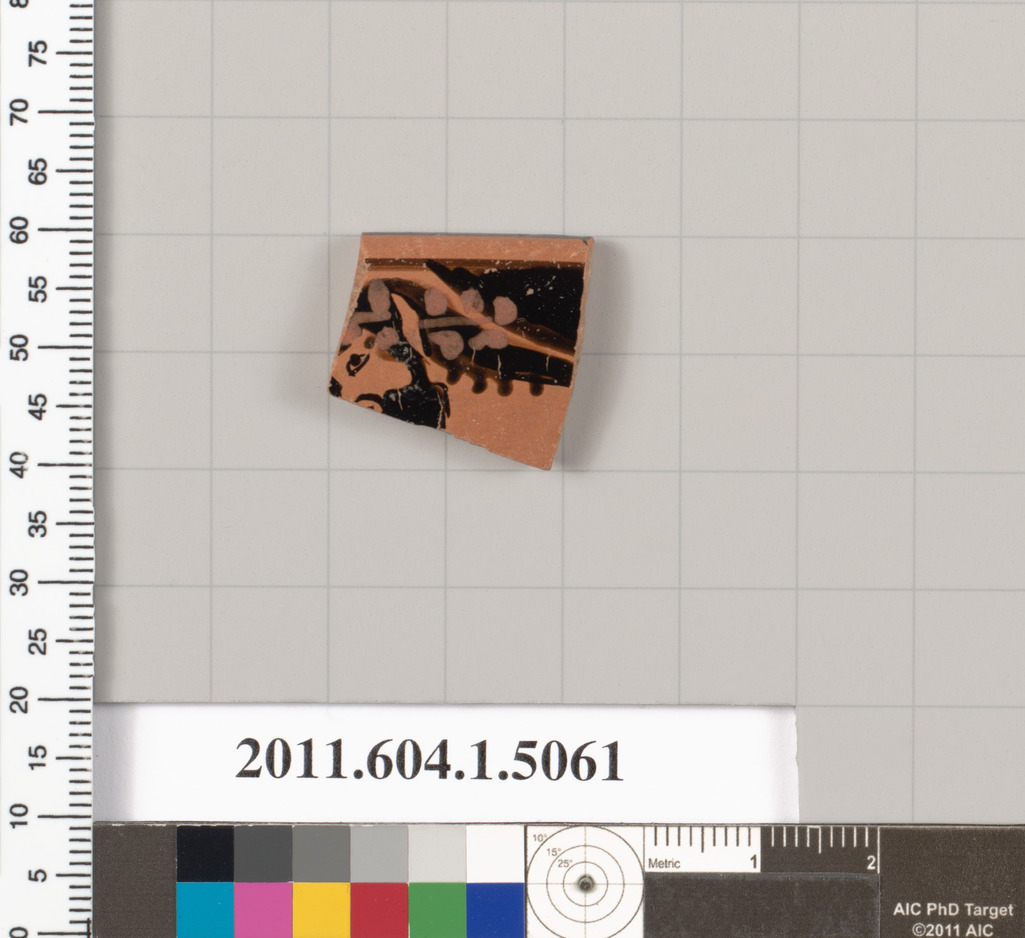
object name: kylix fragment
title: Terracotta rim fragment of a kylix (drinking cup)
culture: greek, attic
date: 510-500 BCE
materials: terracotta